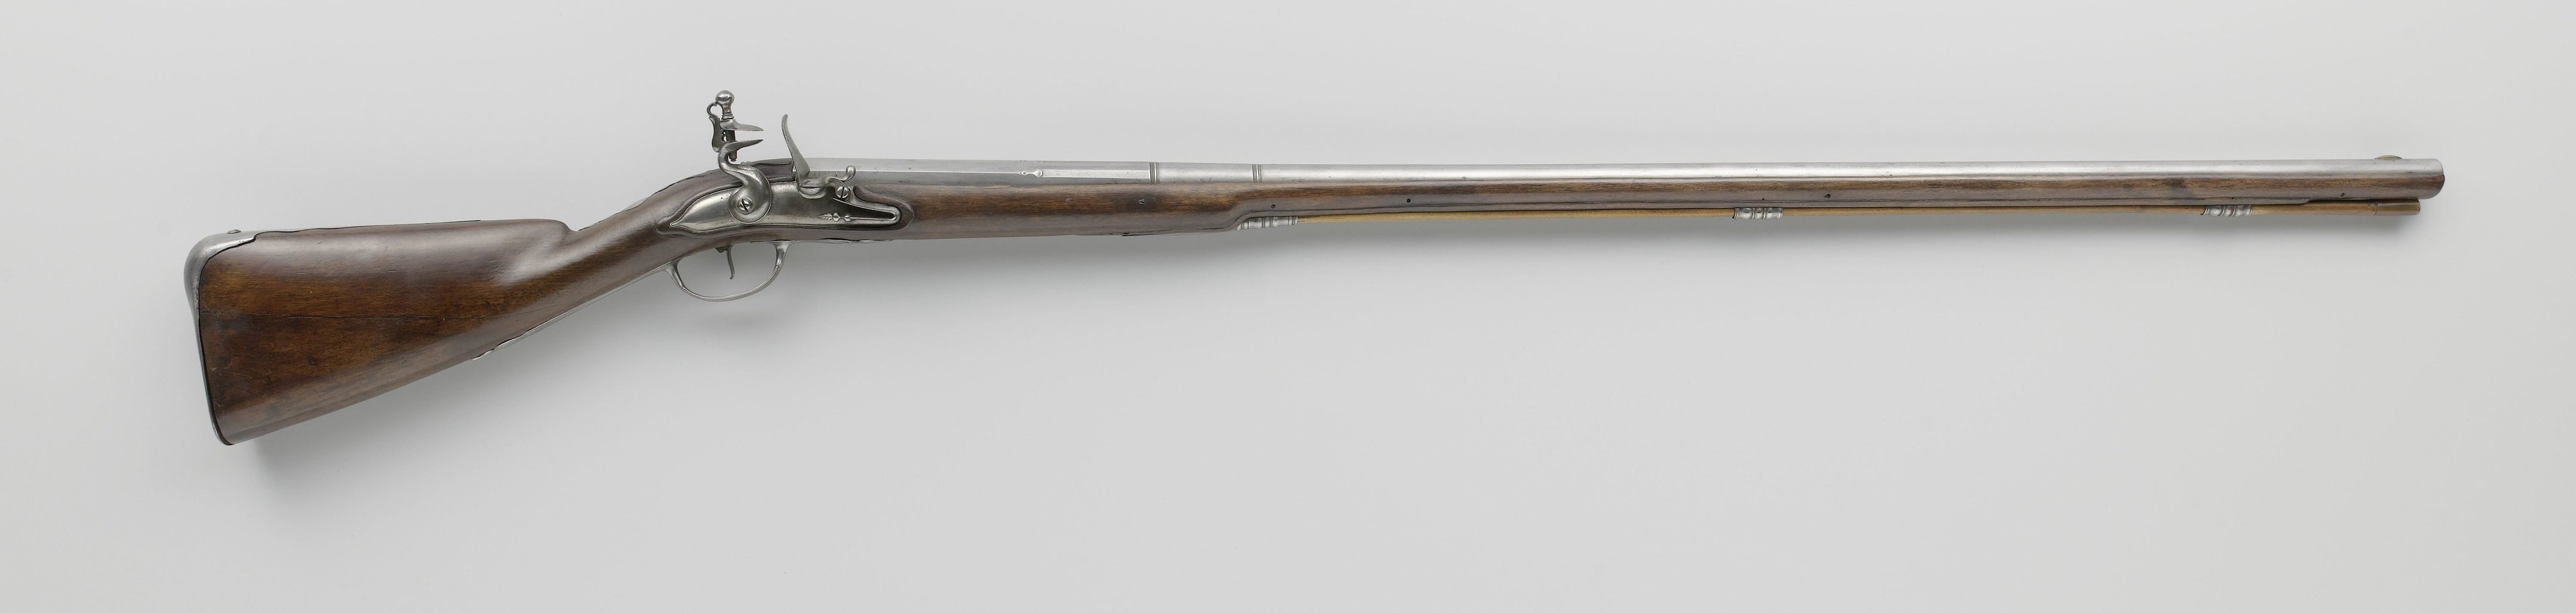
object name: jachtgeweer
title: Vuursteenjachtgeweer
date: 1690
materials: brass, horn, iron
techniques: printing, cutting, engraving, striking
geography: maastricht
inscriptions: stamp: ‘N45; ZO (20); N7’, signature: ‘VAN WALSEN en A MASTRICHT’, mark: ‘Pi’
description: De slotplaat is gesigneerd. De loop is onderop gestempeld met Pi binnen een bekroond schild en voorzien van een geelkoperen vizierkorrel. De kolf is eenvoudig gesneden. Het ijzeren beslag bestaat uit drie laadstokkokers, een accoladevormige schroefplaat, een duimplaat met gebeiteld lofwerk aan onder- en bovenkant en een kolfplaat gestempeld N45 en met de inscripties ZO (20) en N7; de laadstokkoker heeft een kap van koehoorn.